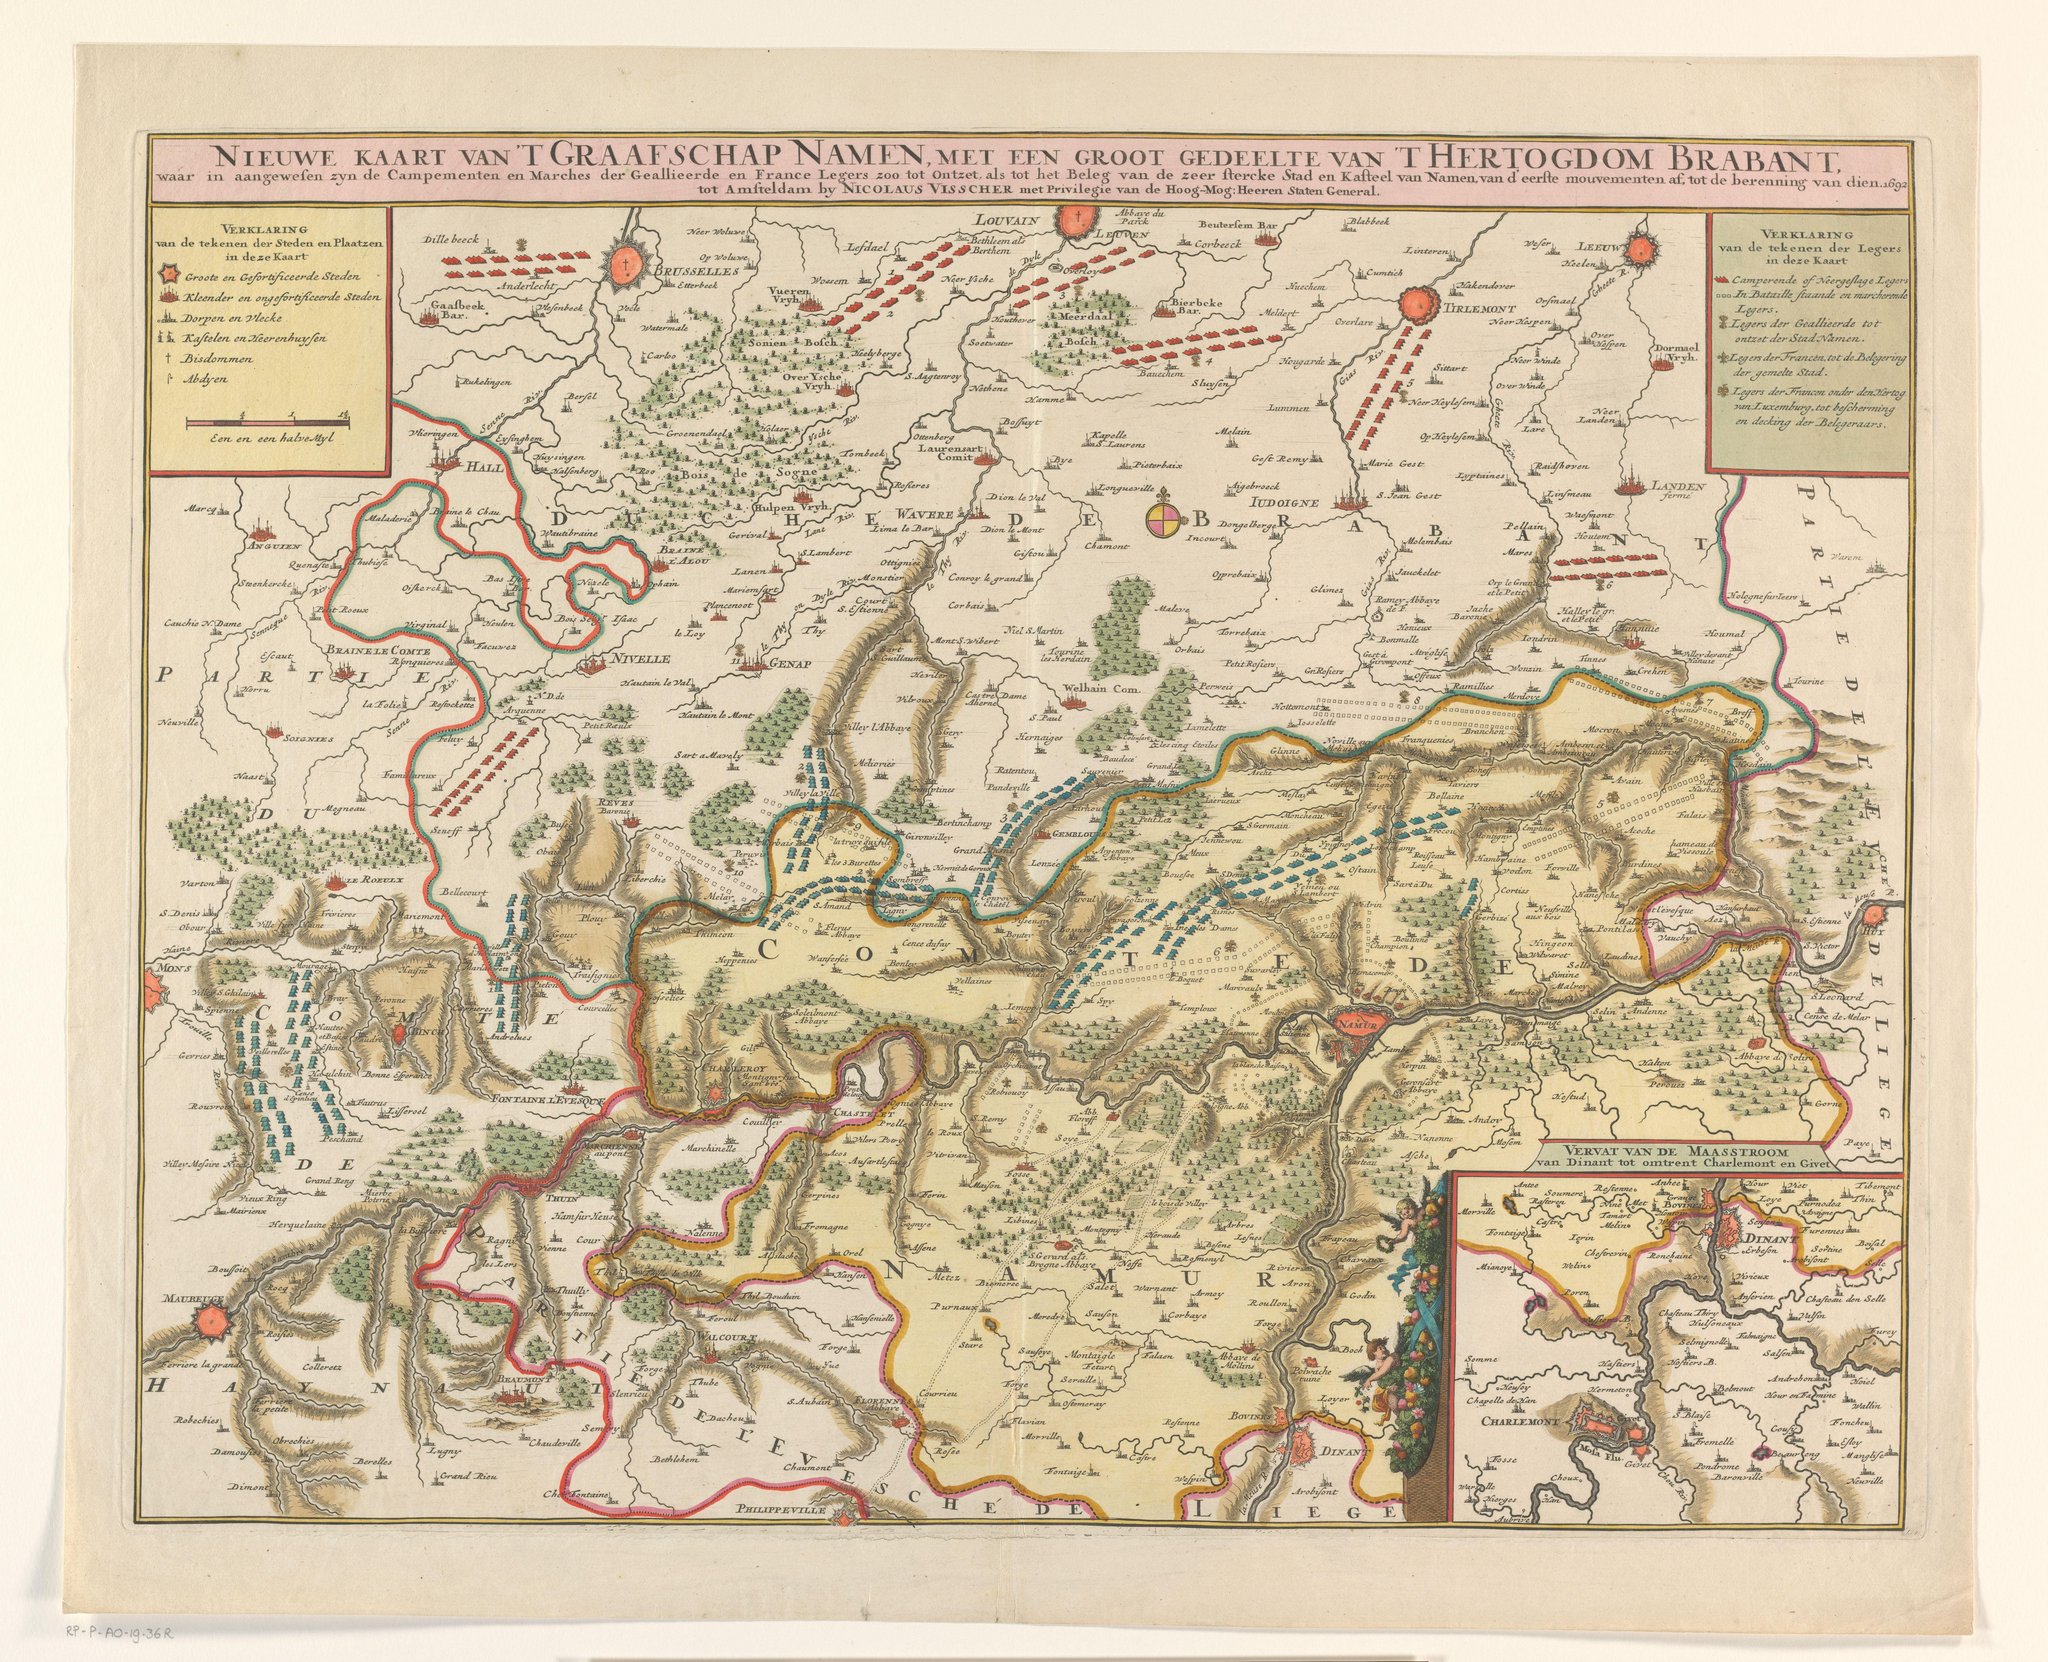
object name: print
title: Kaart van het graafschap Namen met de posities van de Geallieerde en Franse legers, 1692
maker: Anonymous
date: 1692-1720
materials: paper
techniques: engraving, etching, hand coloring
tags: maps of separate countries or regions, namur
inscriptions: collector's mark: Lugt 2228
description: Kaart van het graafschap Namen waarop de posities van de Geallieerde en Franse legers zijn aangegeven, 1692. De titel in een balk boven de kaart. Rechtsonder een inzet met een kaart van het loopgebied van de Maas onder Dinant. Linksboven een kader met legenda en onderin een schaalstok: Een en een halve Myl. Rechtsboven nog een legenda.